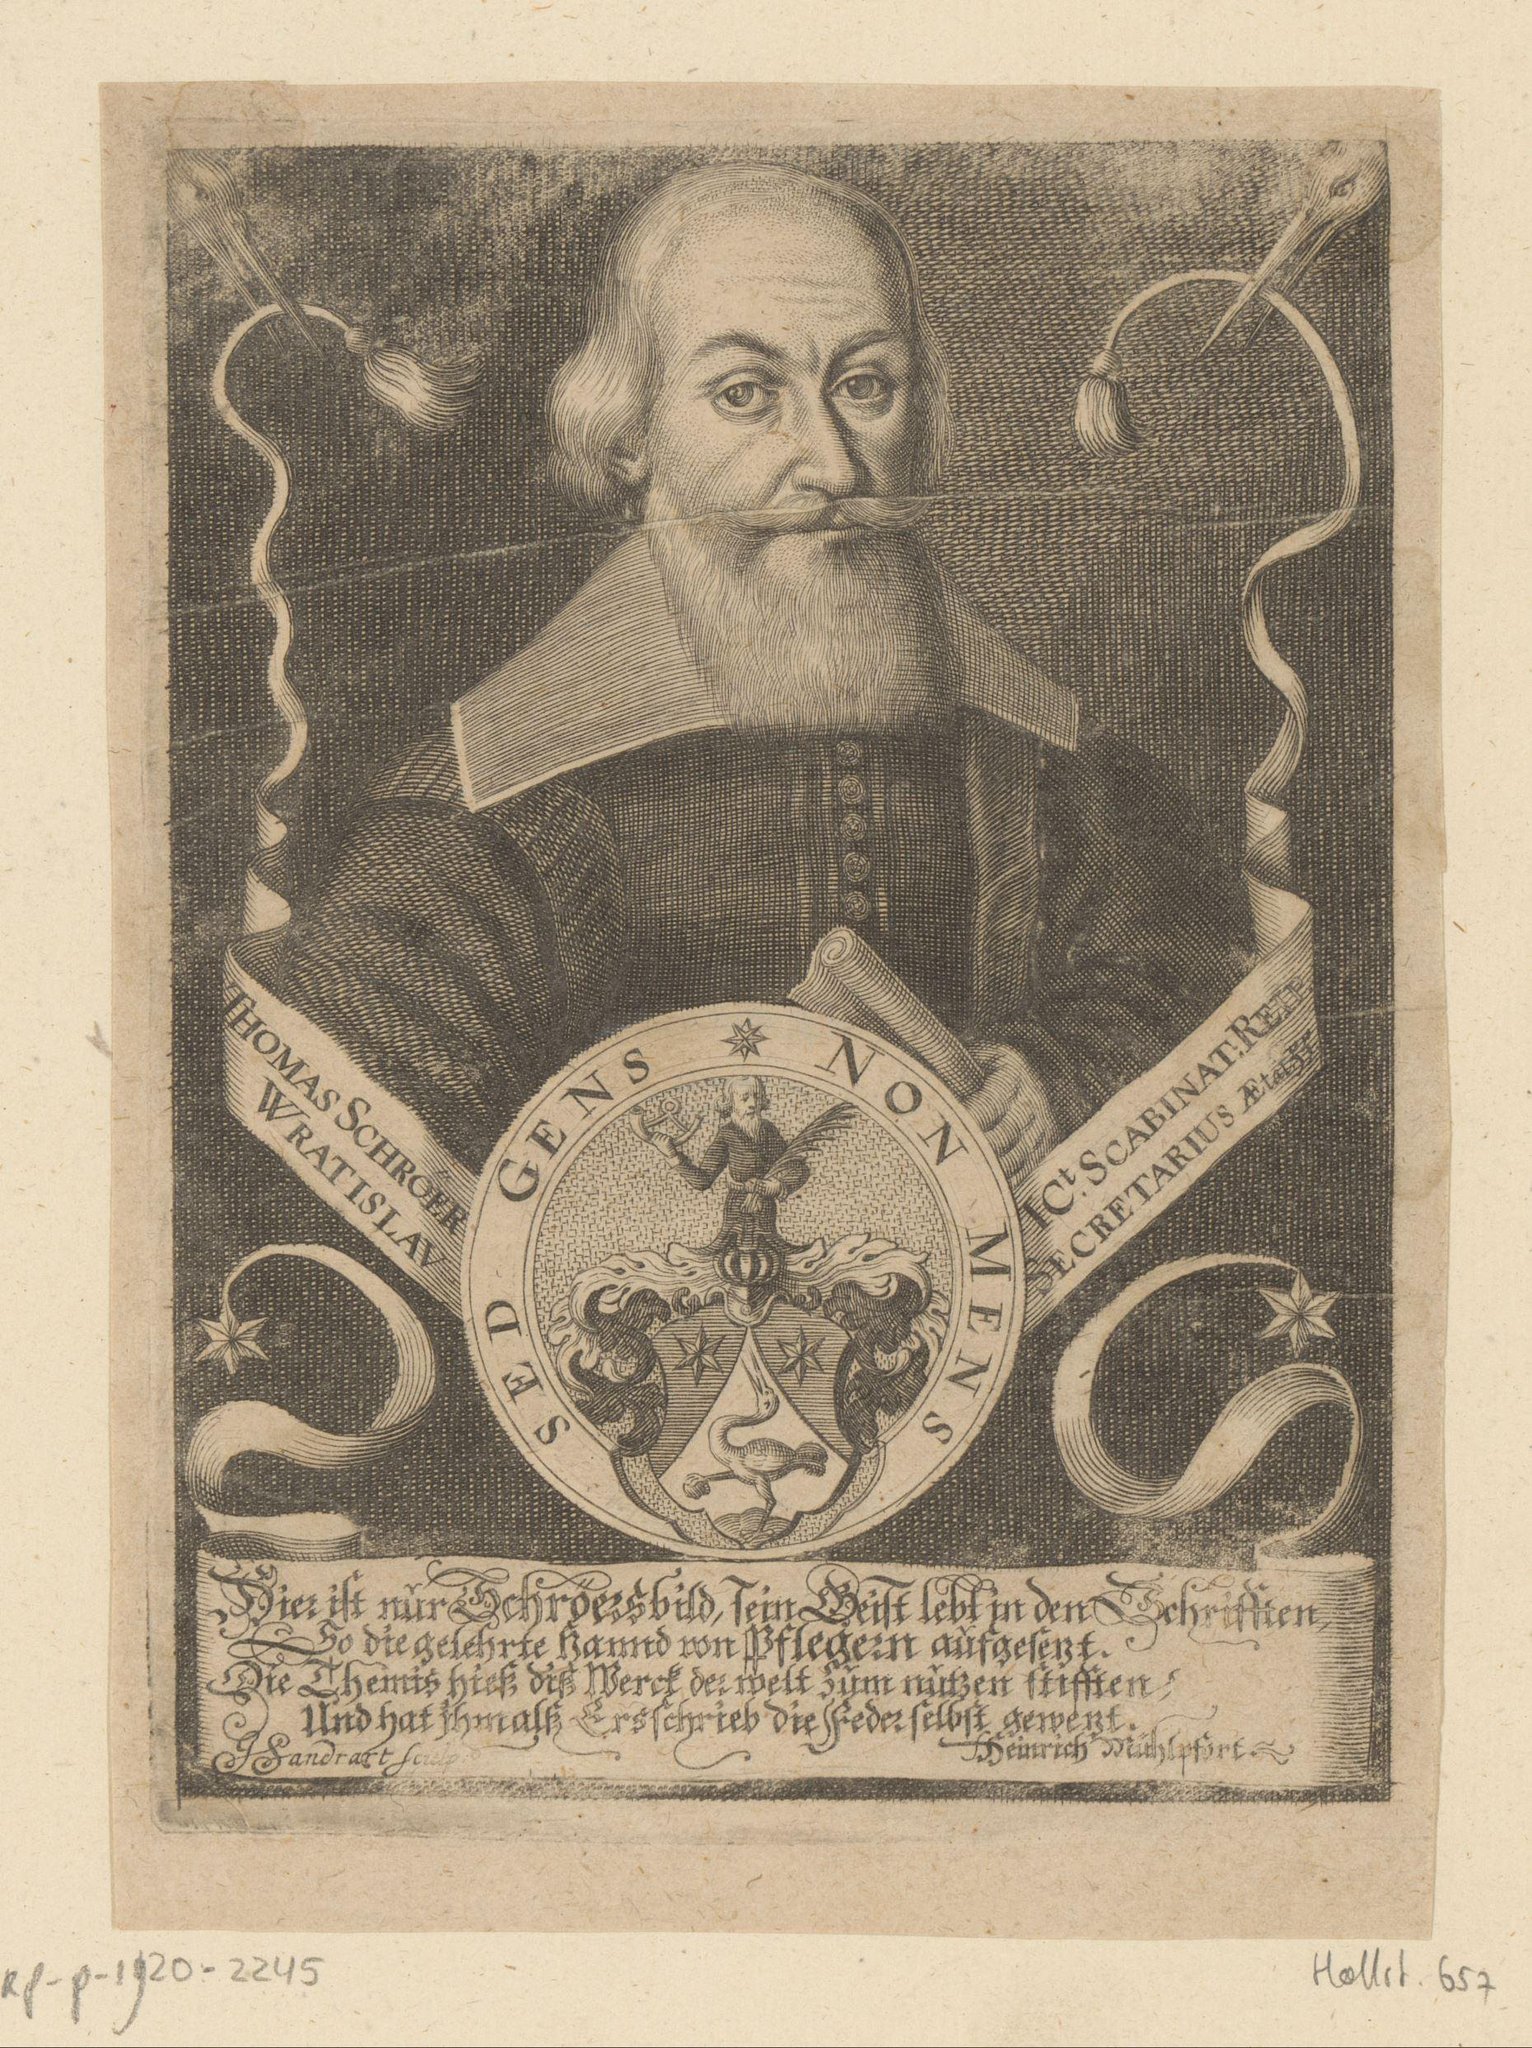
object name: print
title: Portret van Thomas Schröer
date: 1666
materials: paper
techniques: engraving, etching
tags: scroll - ll - scroll unfolded, walker and runner birds: ostrich, historical persons, armorial bearing, heraldry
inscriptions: collector's mark: Lugt 2228